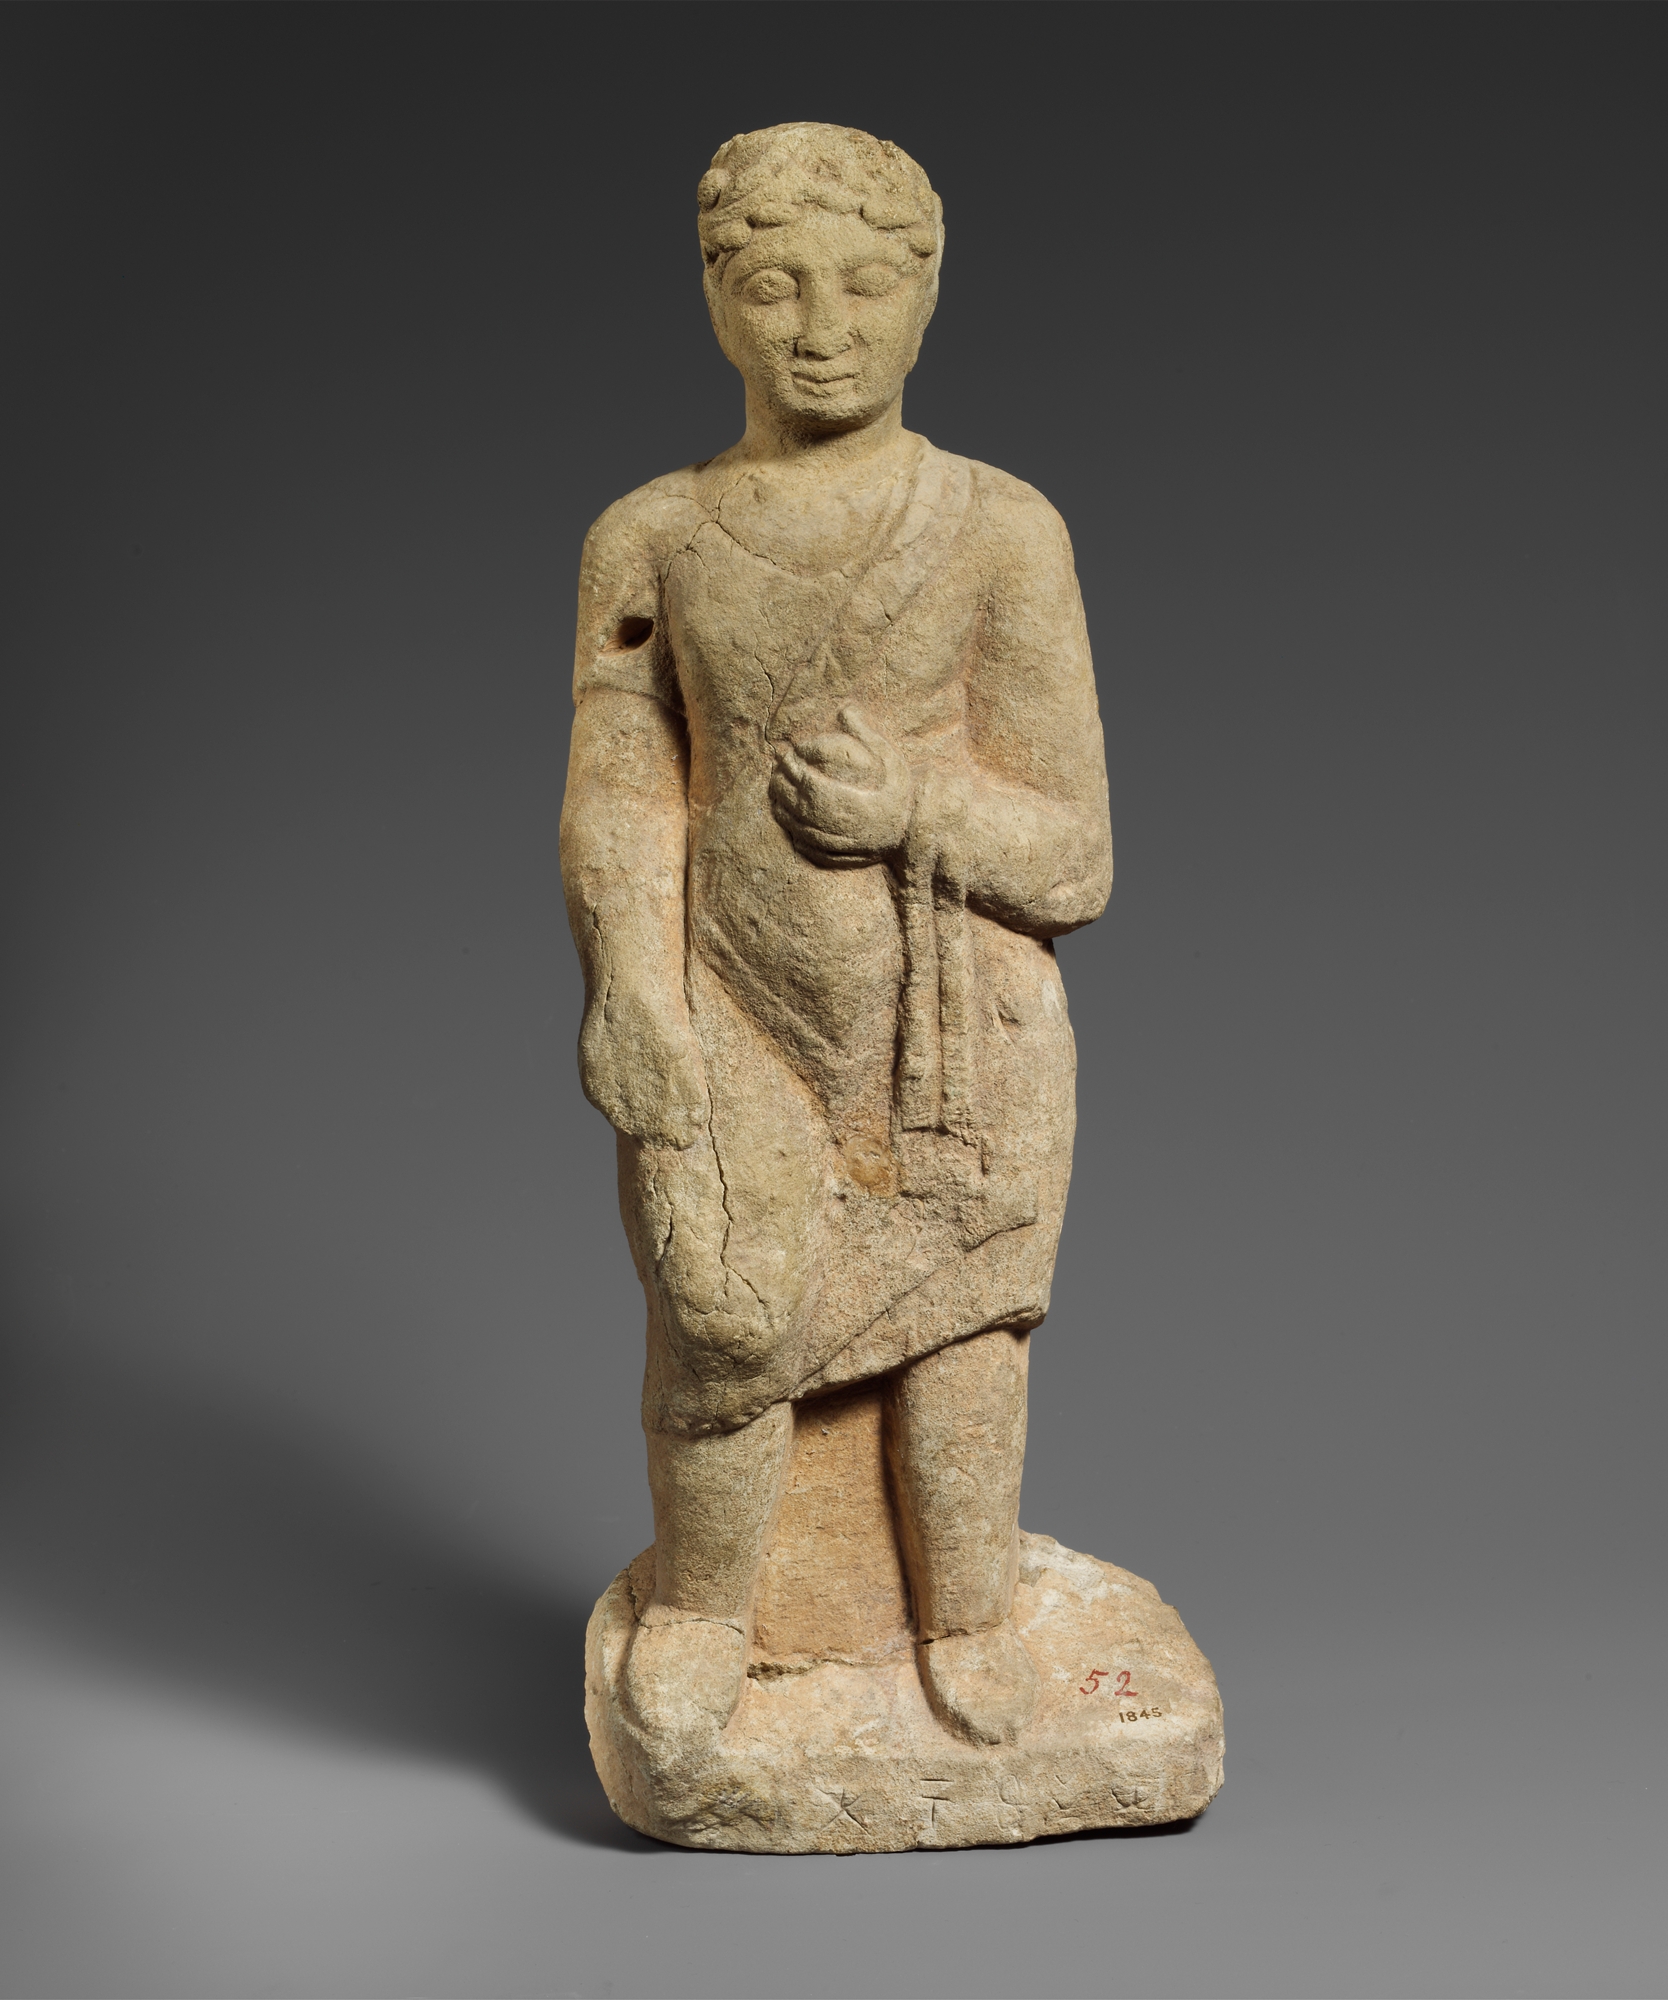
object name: statuette to the god of the wine press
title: Limestone statuette of a beardless male votary with a wreath of leaves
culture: cypriot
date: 310-30 BCE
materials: limestone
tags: men